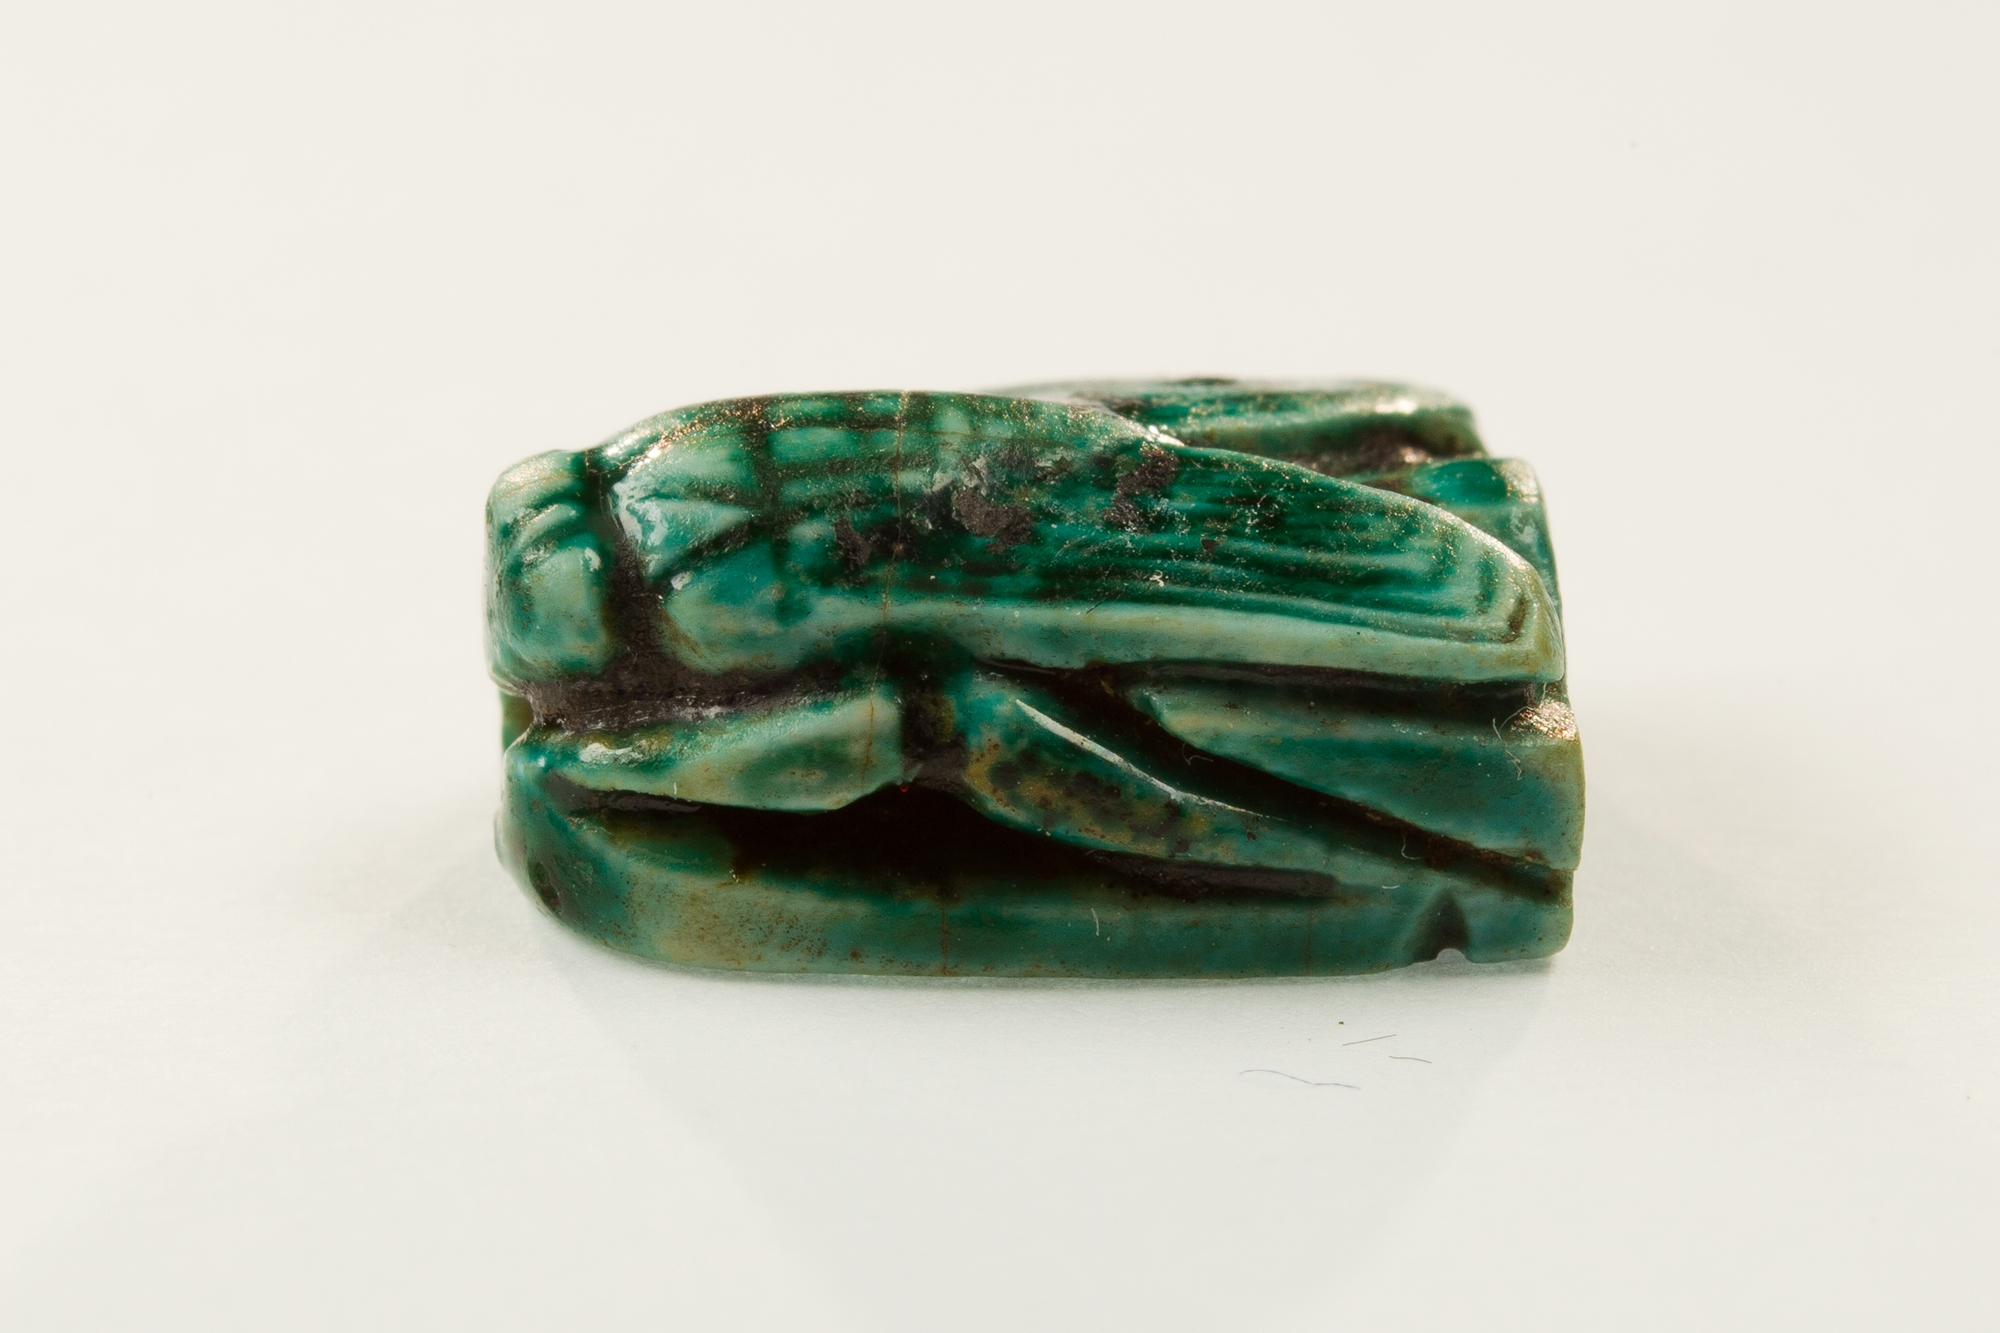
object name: amulet, fly, queen ahhotep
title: Design Amulet in the Form of a Fly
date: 1550-1525 BCE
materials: stone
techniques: glazing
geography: egypt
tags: insects